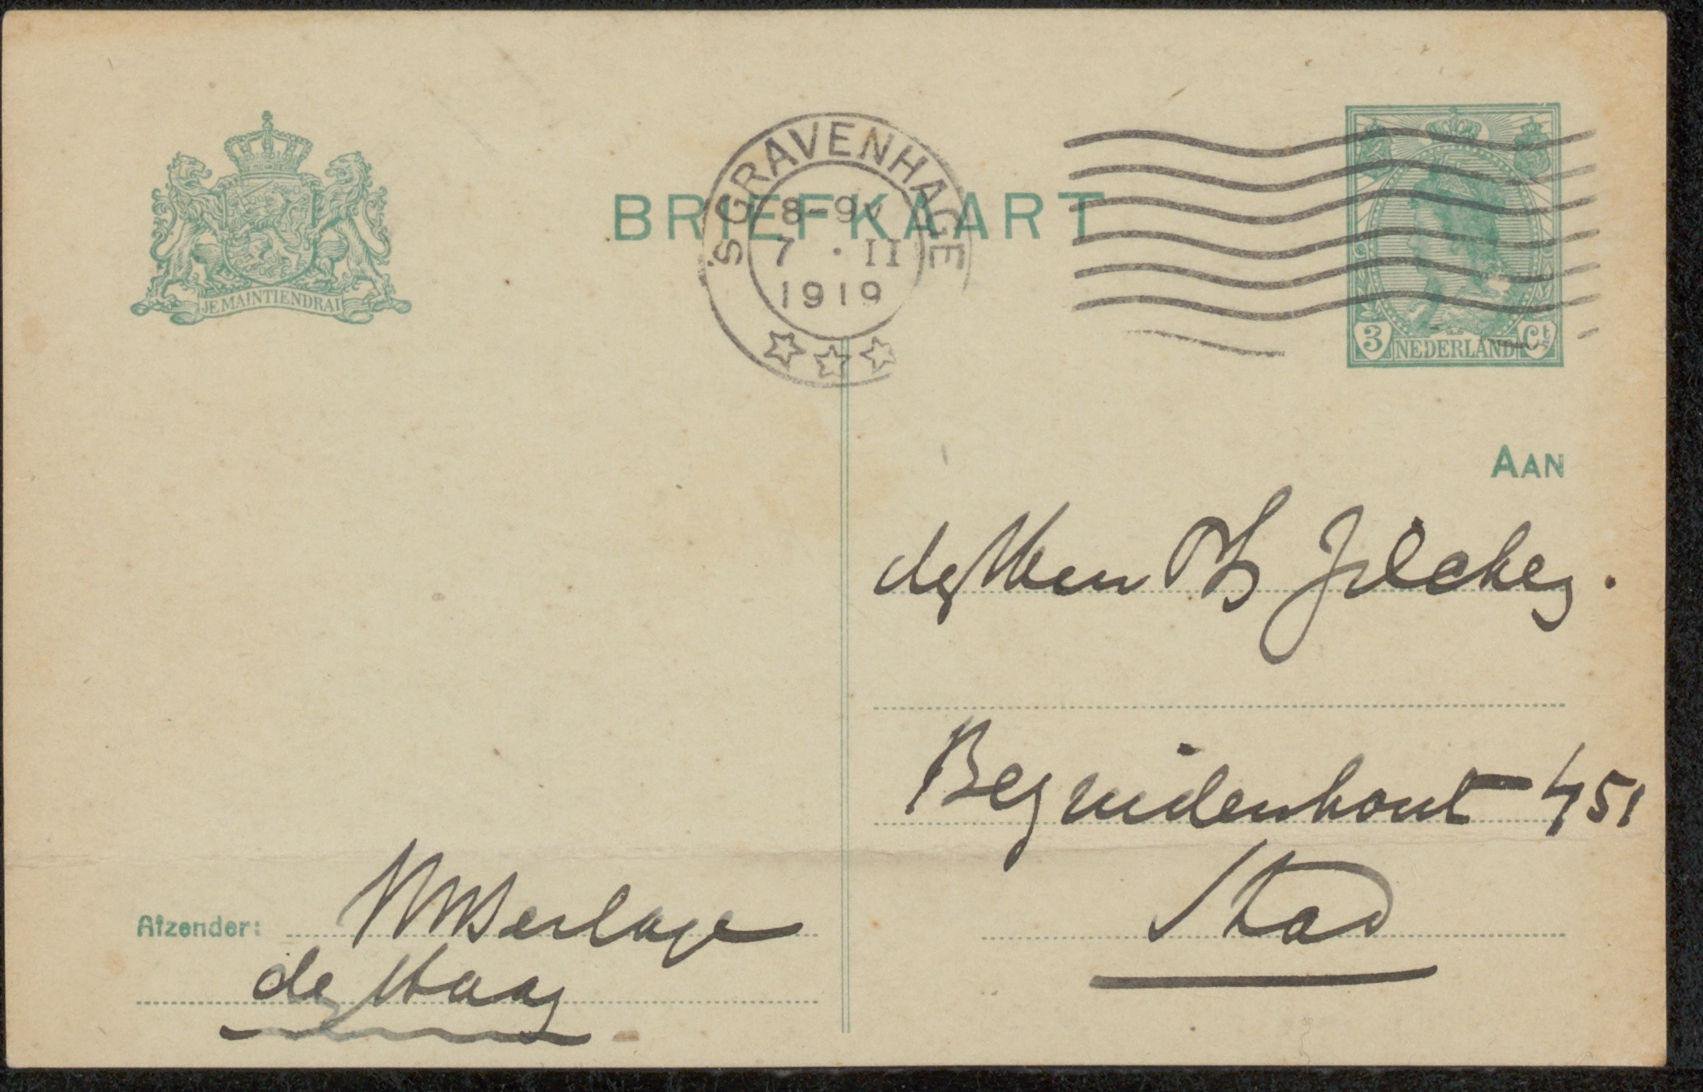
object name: postcard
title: Briefkaart aan Philip Zilcken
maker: hendrik petrus berlage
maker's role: draughtsman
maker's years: 1856-1934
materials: cardboard, ink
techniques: pen, writing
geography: the hague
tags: painter, philip zilcken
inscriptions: collector's mark: ‘RPK’